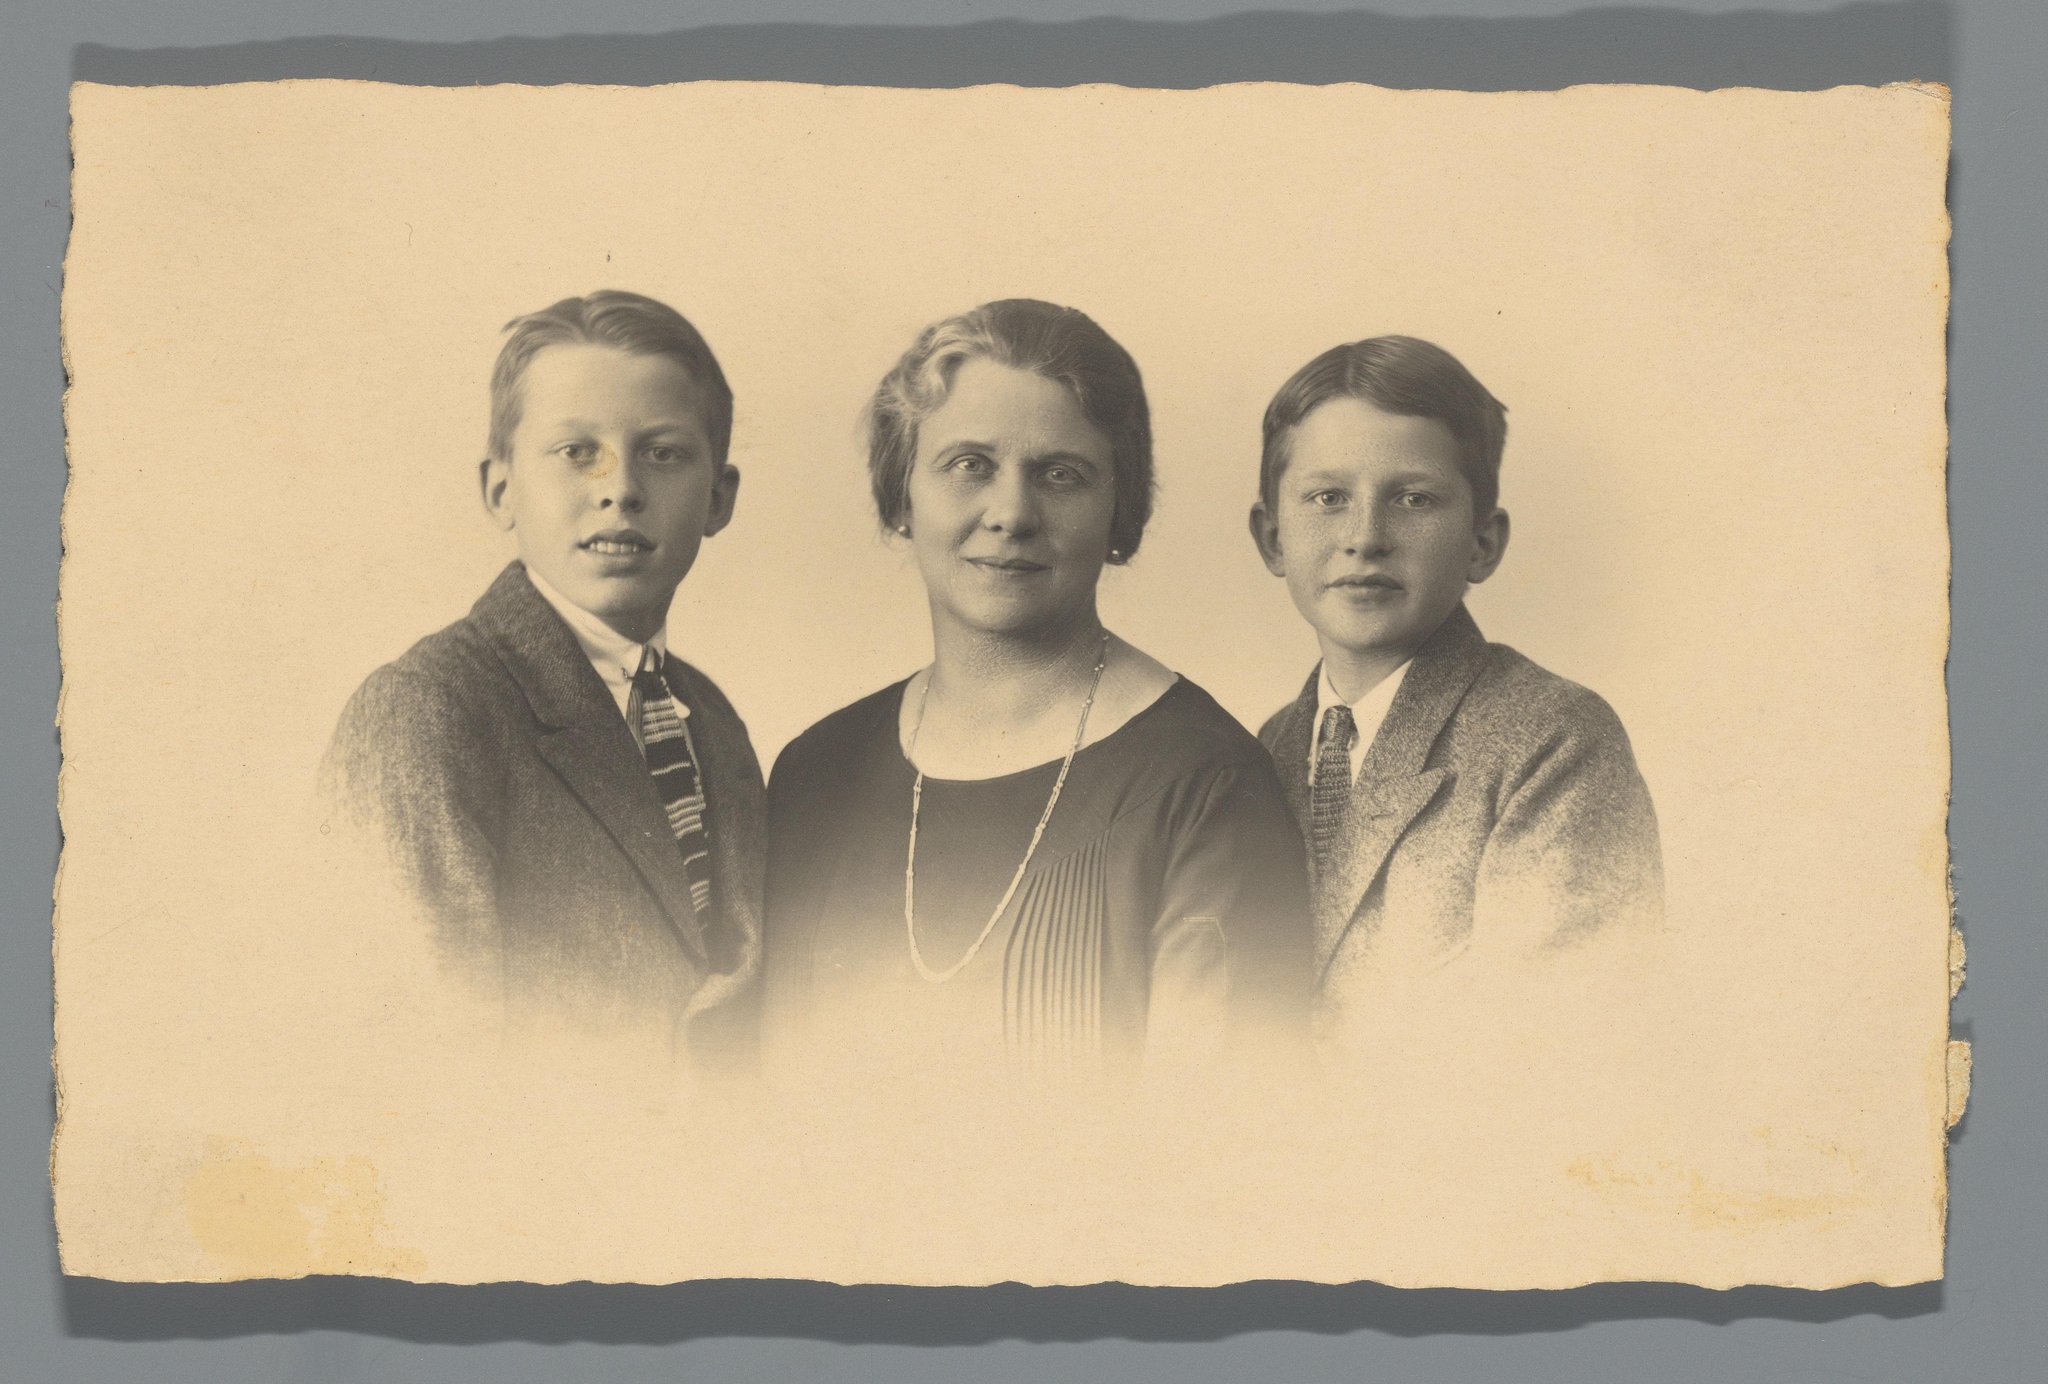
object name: photograph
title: Line van den Berg tussen twee zonen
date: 1923-1924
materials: photographic support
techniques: photography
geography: amsterdam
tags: the hague, caroline louise van den berg-van den berg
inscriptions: stamp: ‘-1. Dec. 1924’, inscription: ‘DEC 1924’, inscription: ‘April 1923’, name: ‘FOTO / BAYER’, inscription: ‘... Photo-Couleur, Leidschestraat 87, Amsterdam.’